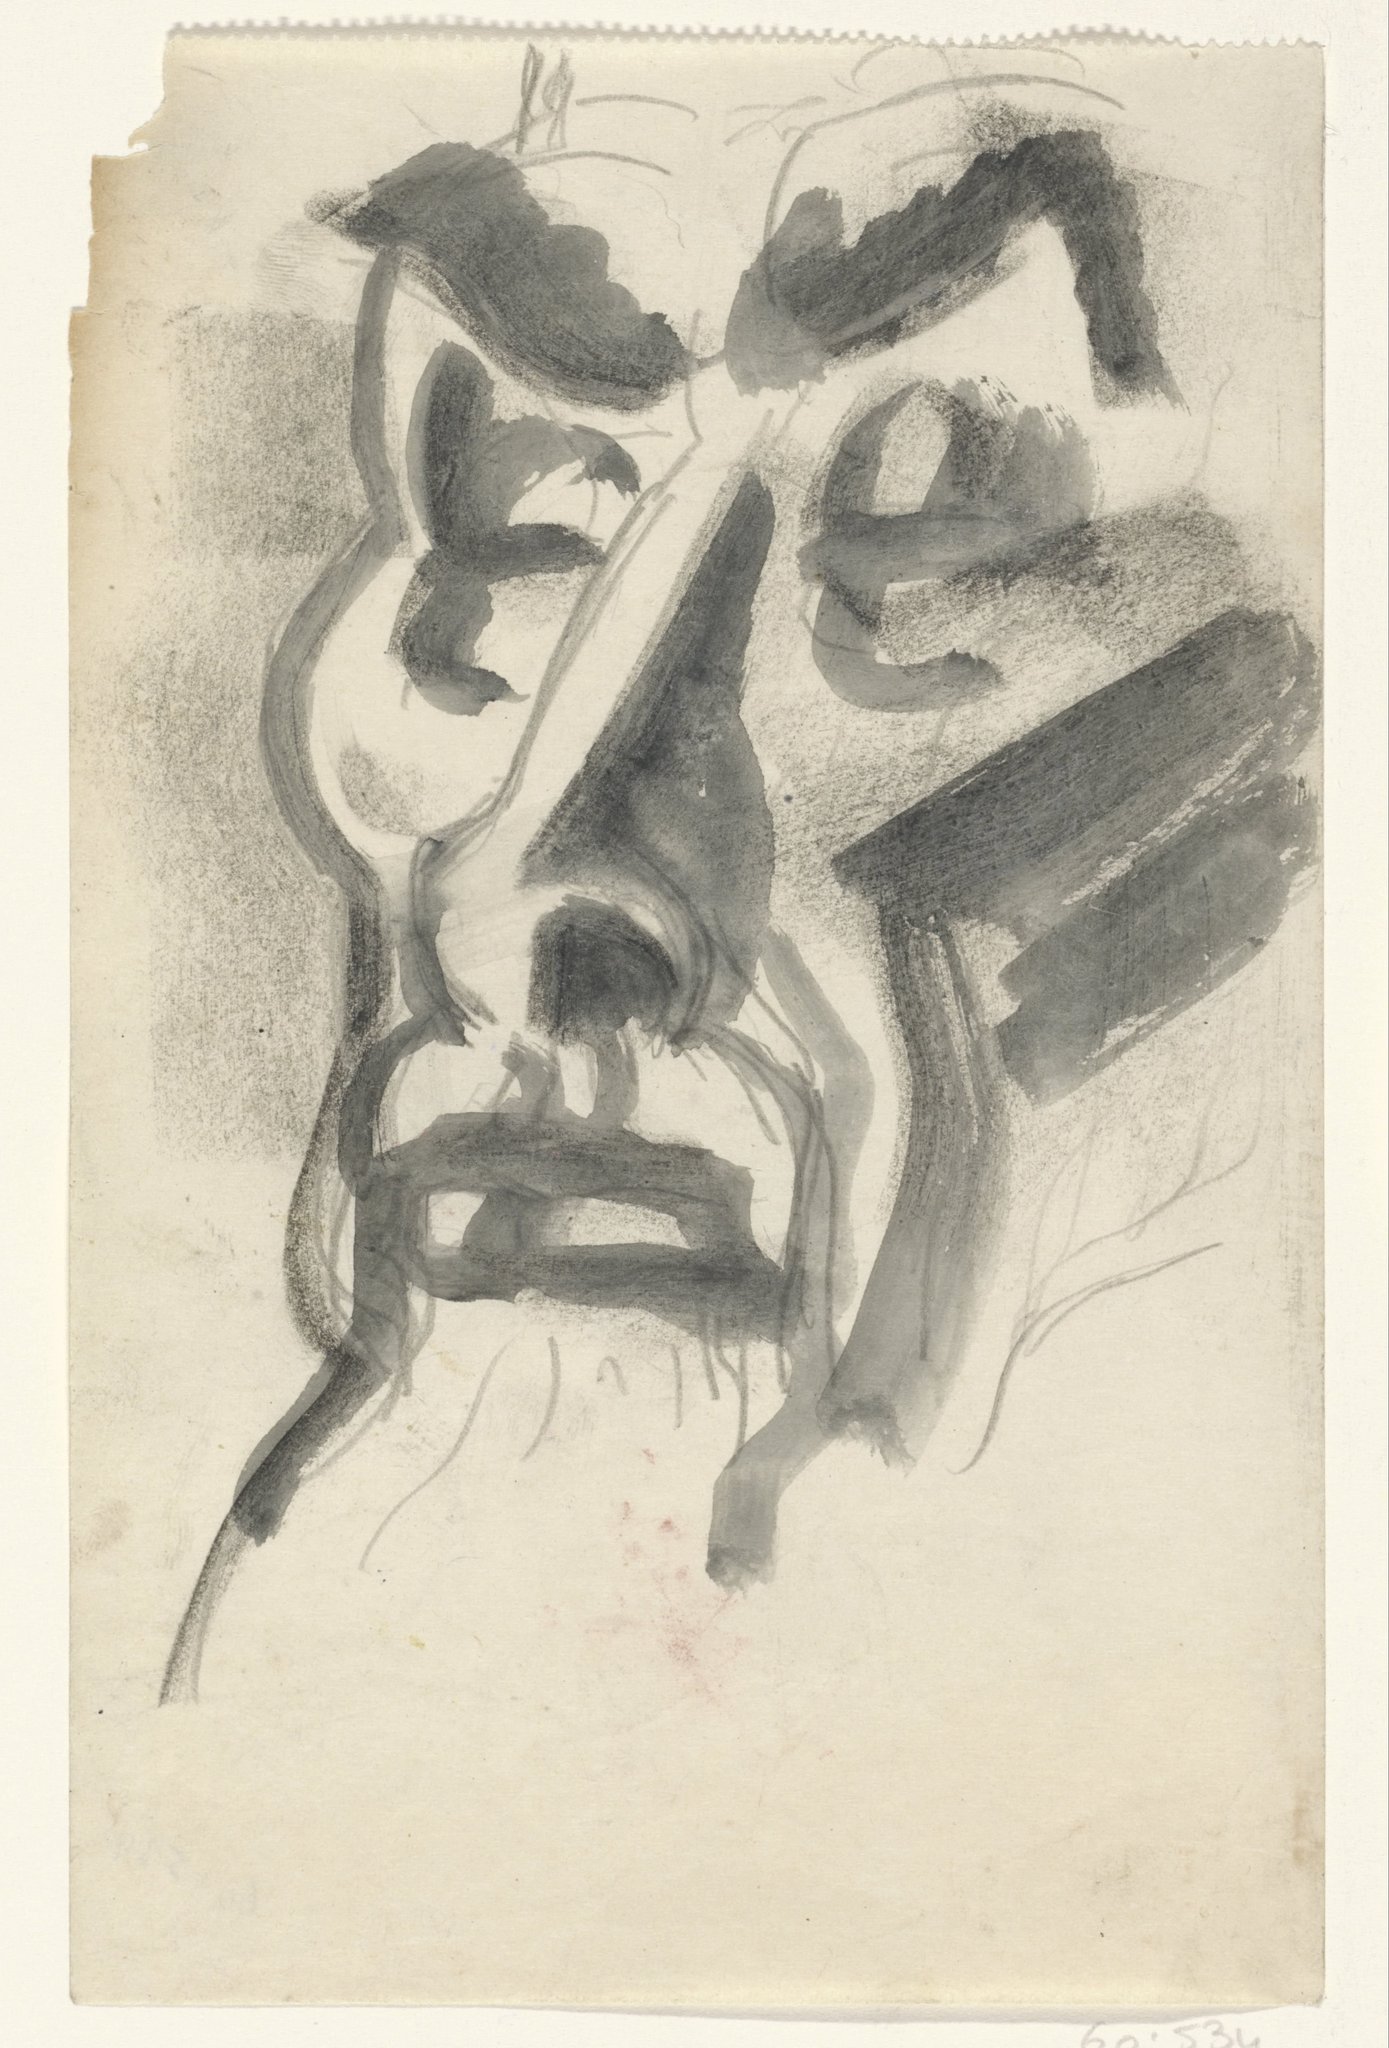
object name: drawing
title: Portret van Jan Toorop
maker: leo gestel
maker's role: draughtsman, print maker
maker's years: 1881-1941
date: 1920-1922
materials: chalk, paper, pencil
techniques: brush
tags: the hague, painter, print maker, draughtsman, jan toorop, historical persons, portrait, self-portrait of draughtsman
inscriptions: collector's mark: Lugt 2228